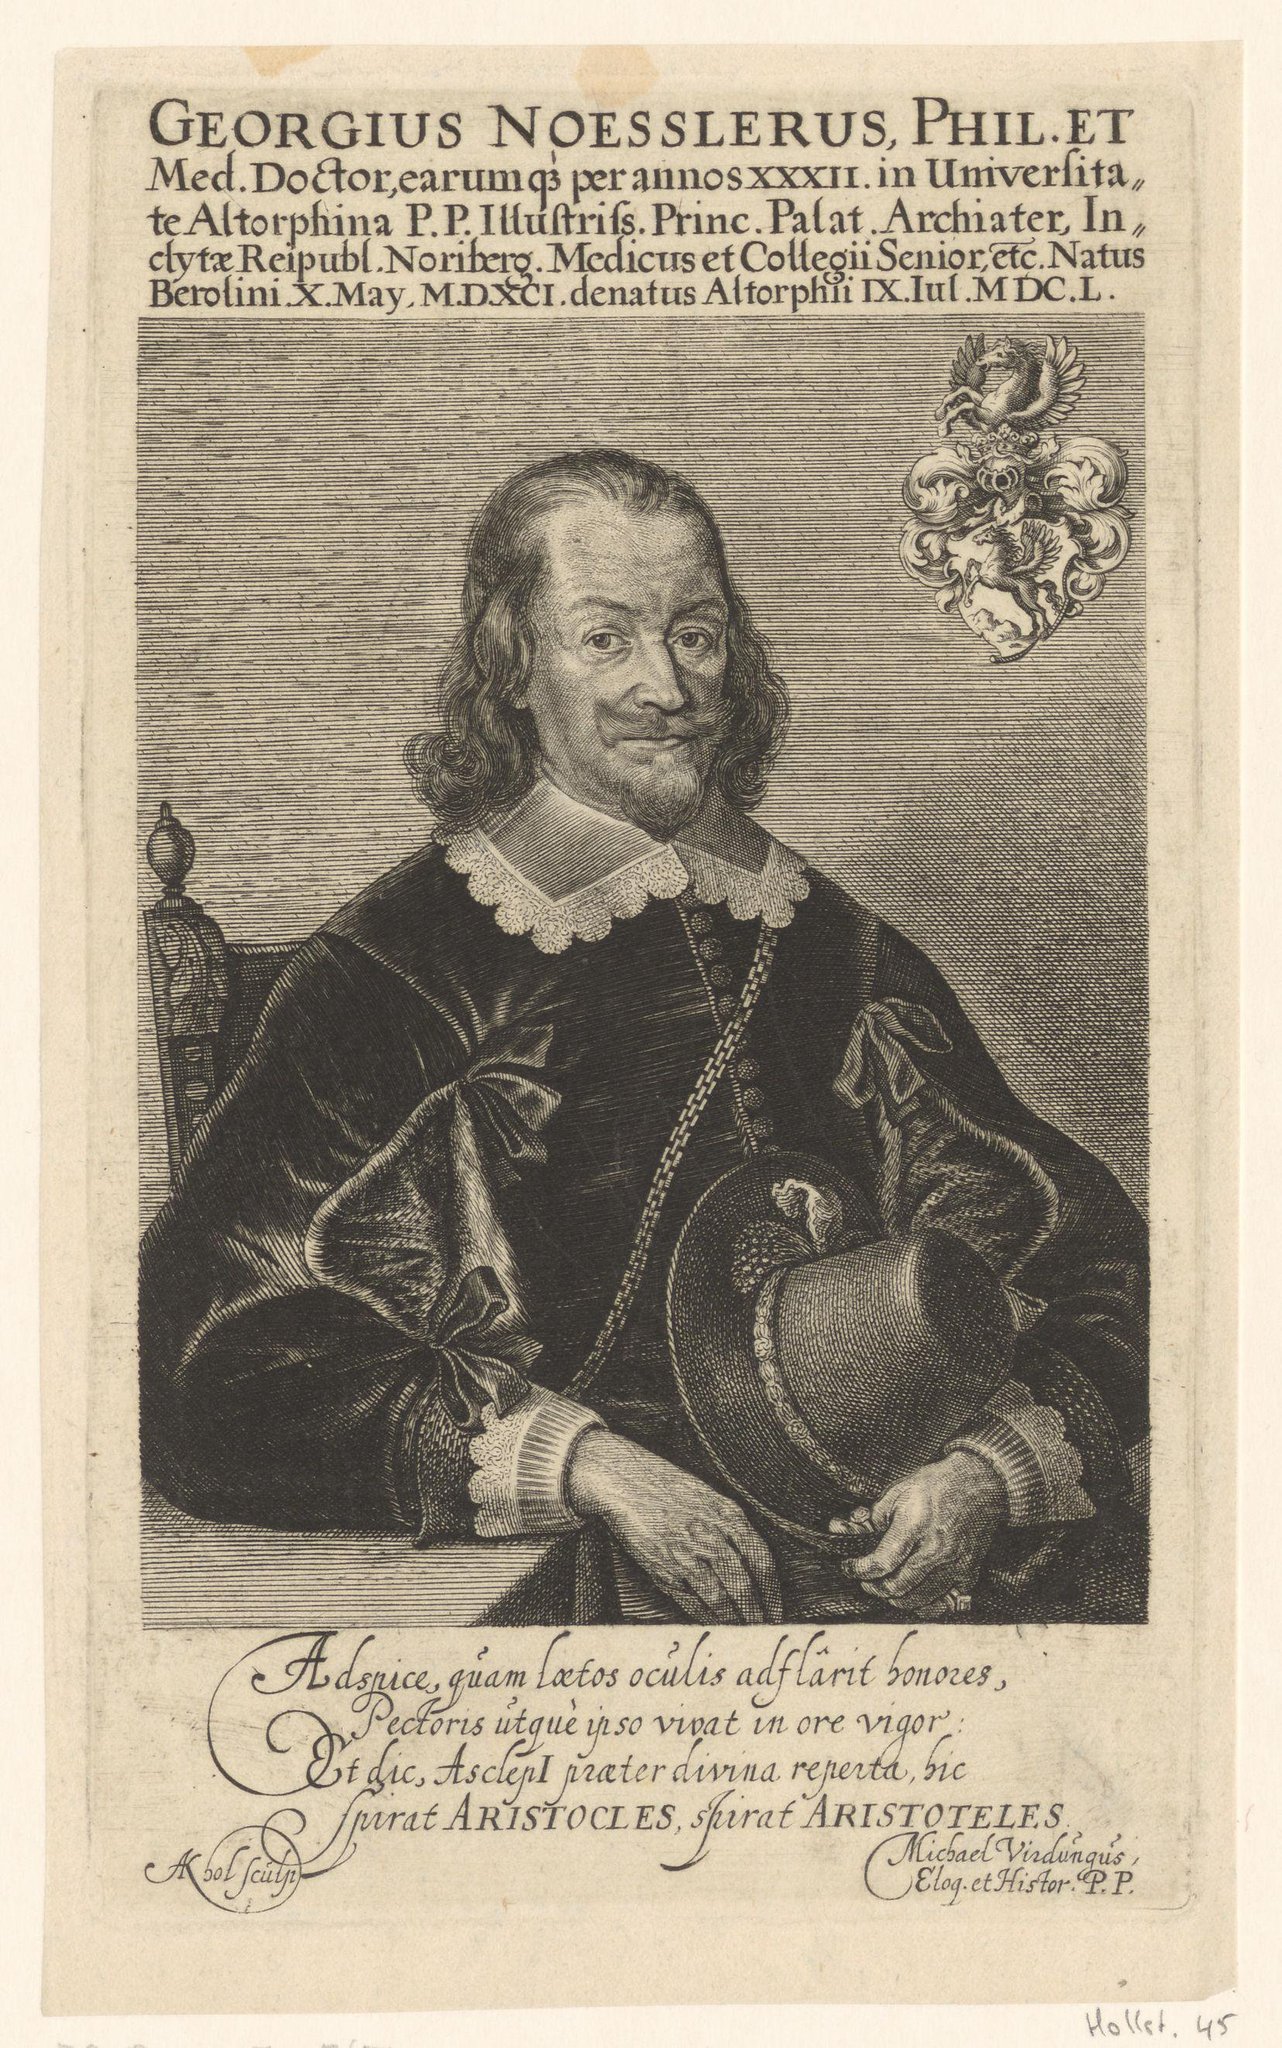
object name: print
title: Portret van Georg Nössler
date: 1650-1657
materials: paper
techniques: engraving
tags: berlin, georg nössler, scholar, philosopher, historical persons, writer, poet, author, physician, doctor (+ portrait of scholar, scientist)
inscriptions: collector's mark: Lugt 2228